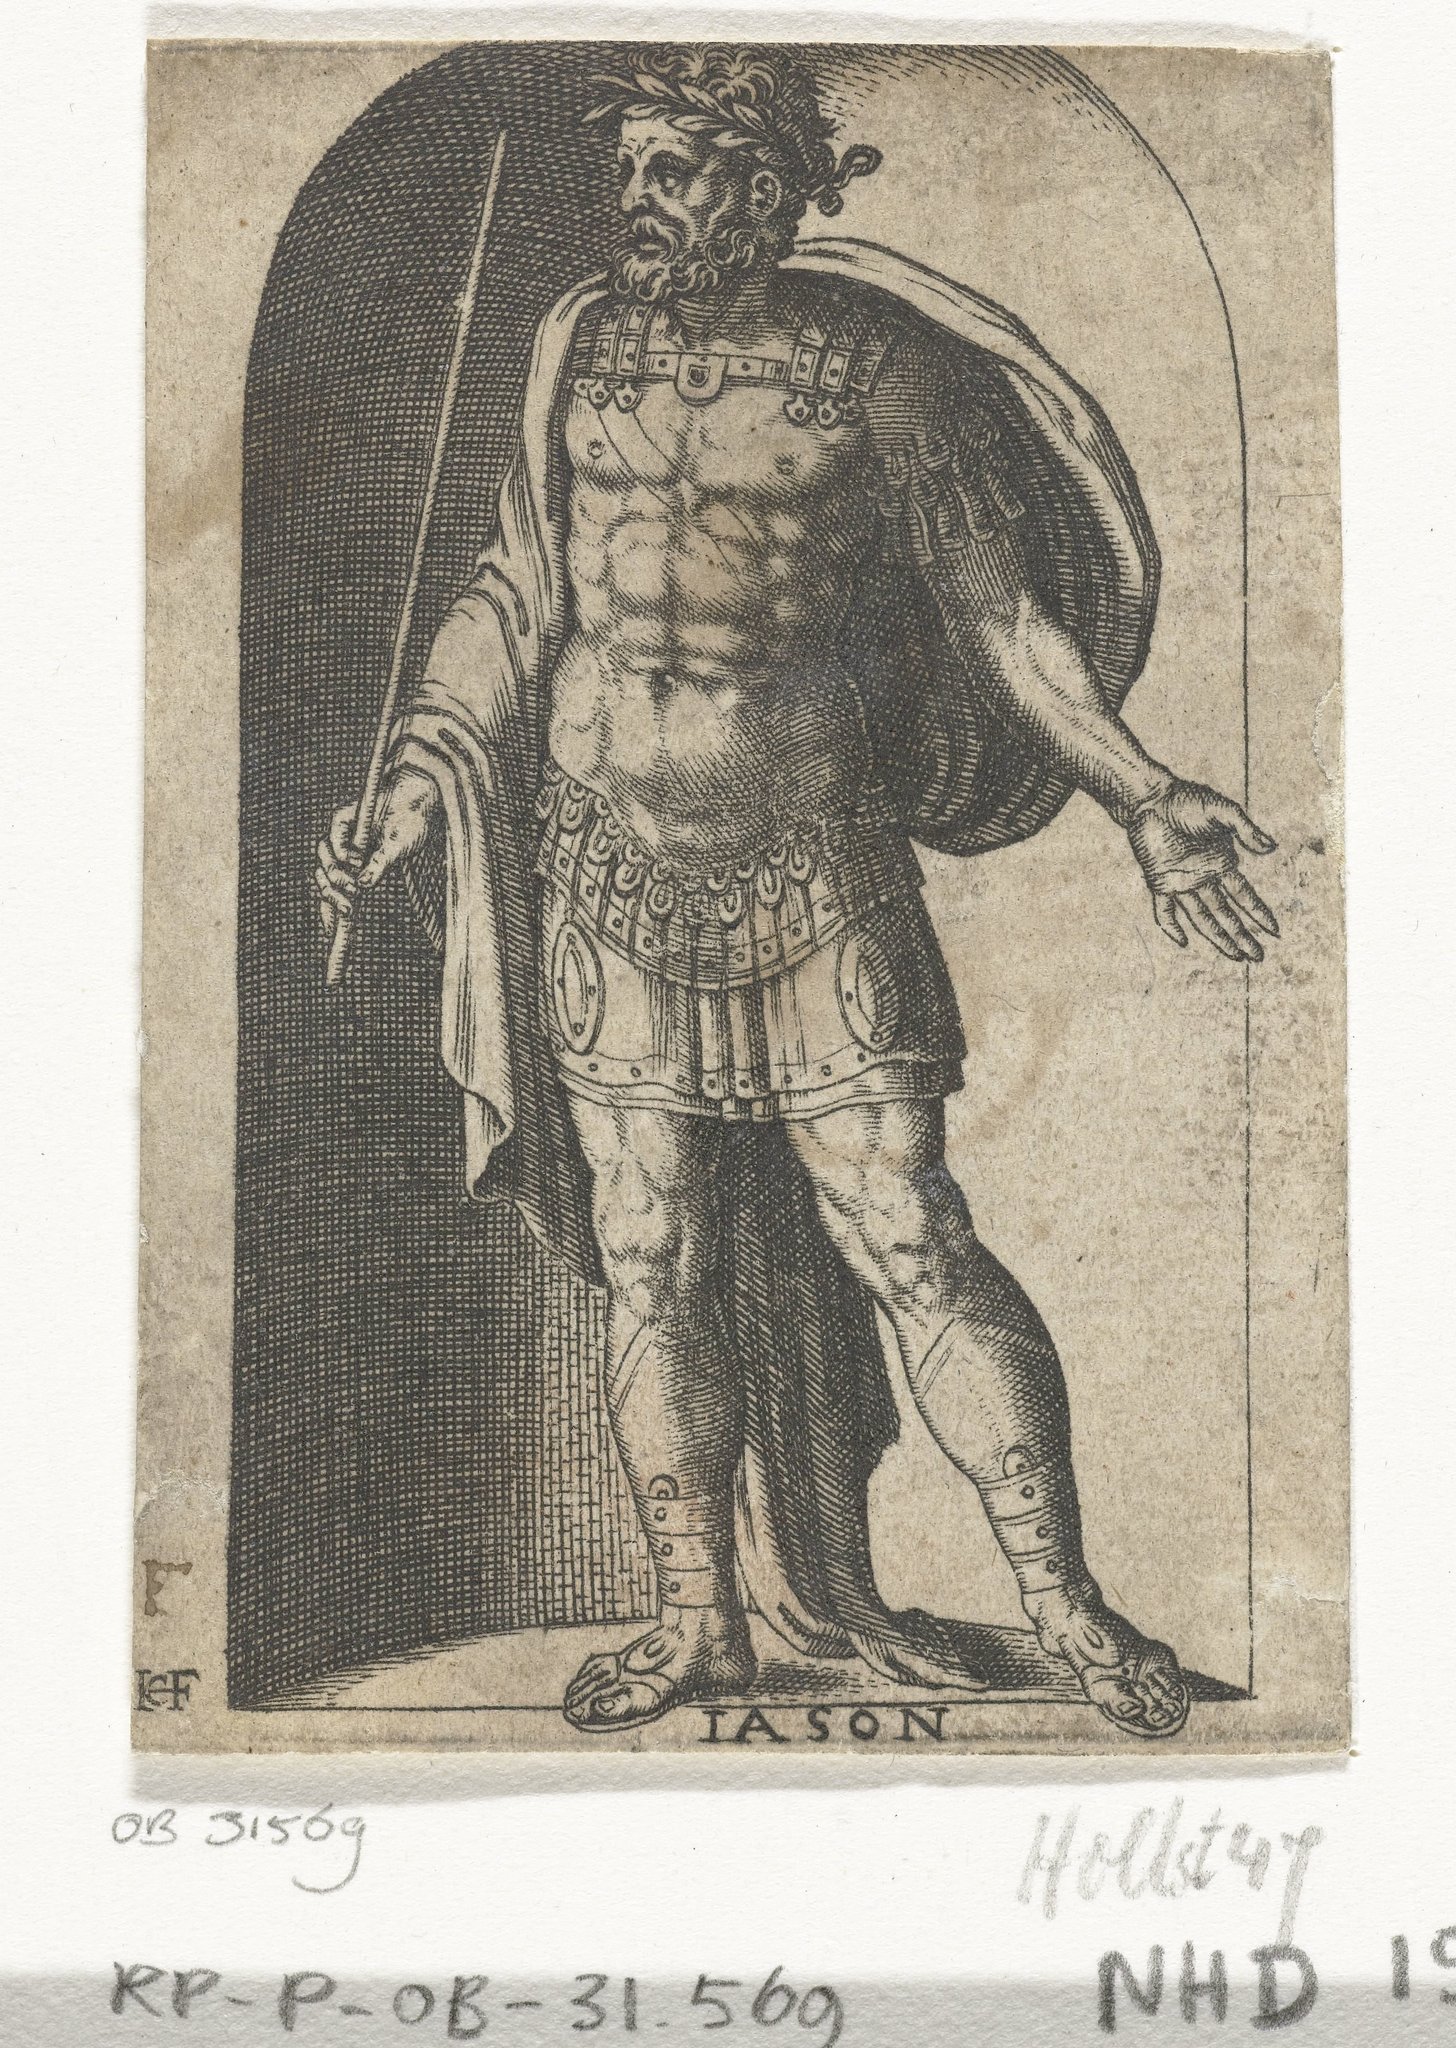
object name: print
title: Jason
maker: hans collaert (i)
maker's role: draughtsman, print maker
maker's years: 1520-1581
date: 1530-1580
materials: paper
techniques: engraving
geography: antwerp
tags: (story of) jason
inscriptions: collector's mark: Lugt 240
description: Jason, de Griekse held die het Gulden Vlies bemachtigde met de Argonauten, in een nis. Hij draagt een harnas en heeft een staf in zijn handen. De prent is deel van een serie met ontwerpen van bekende personen uit de Bijbel, de mythologie en de Oudheid als onderwerp.